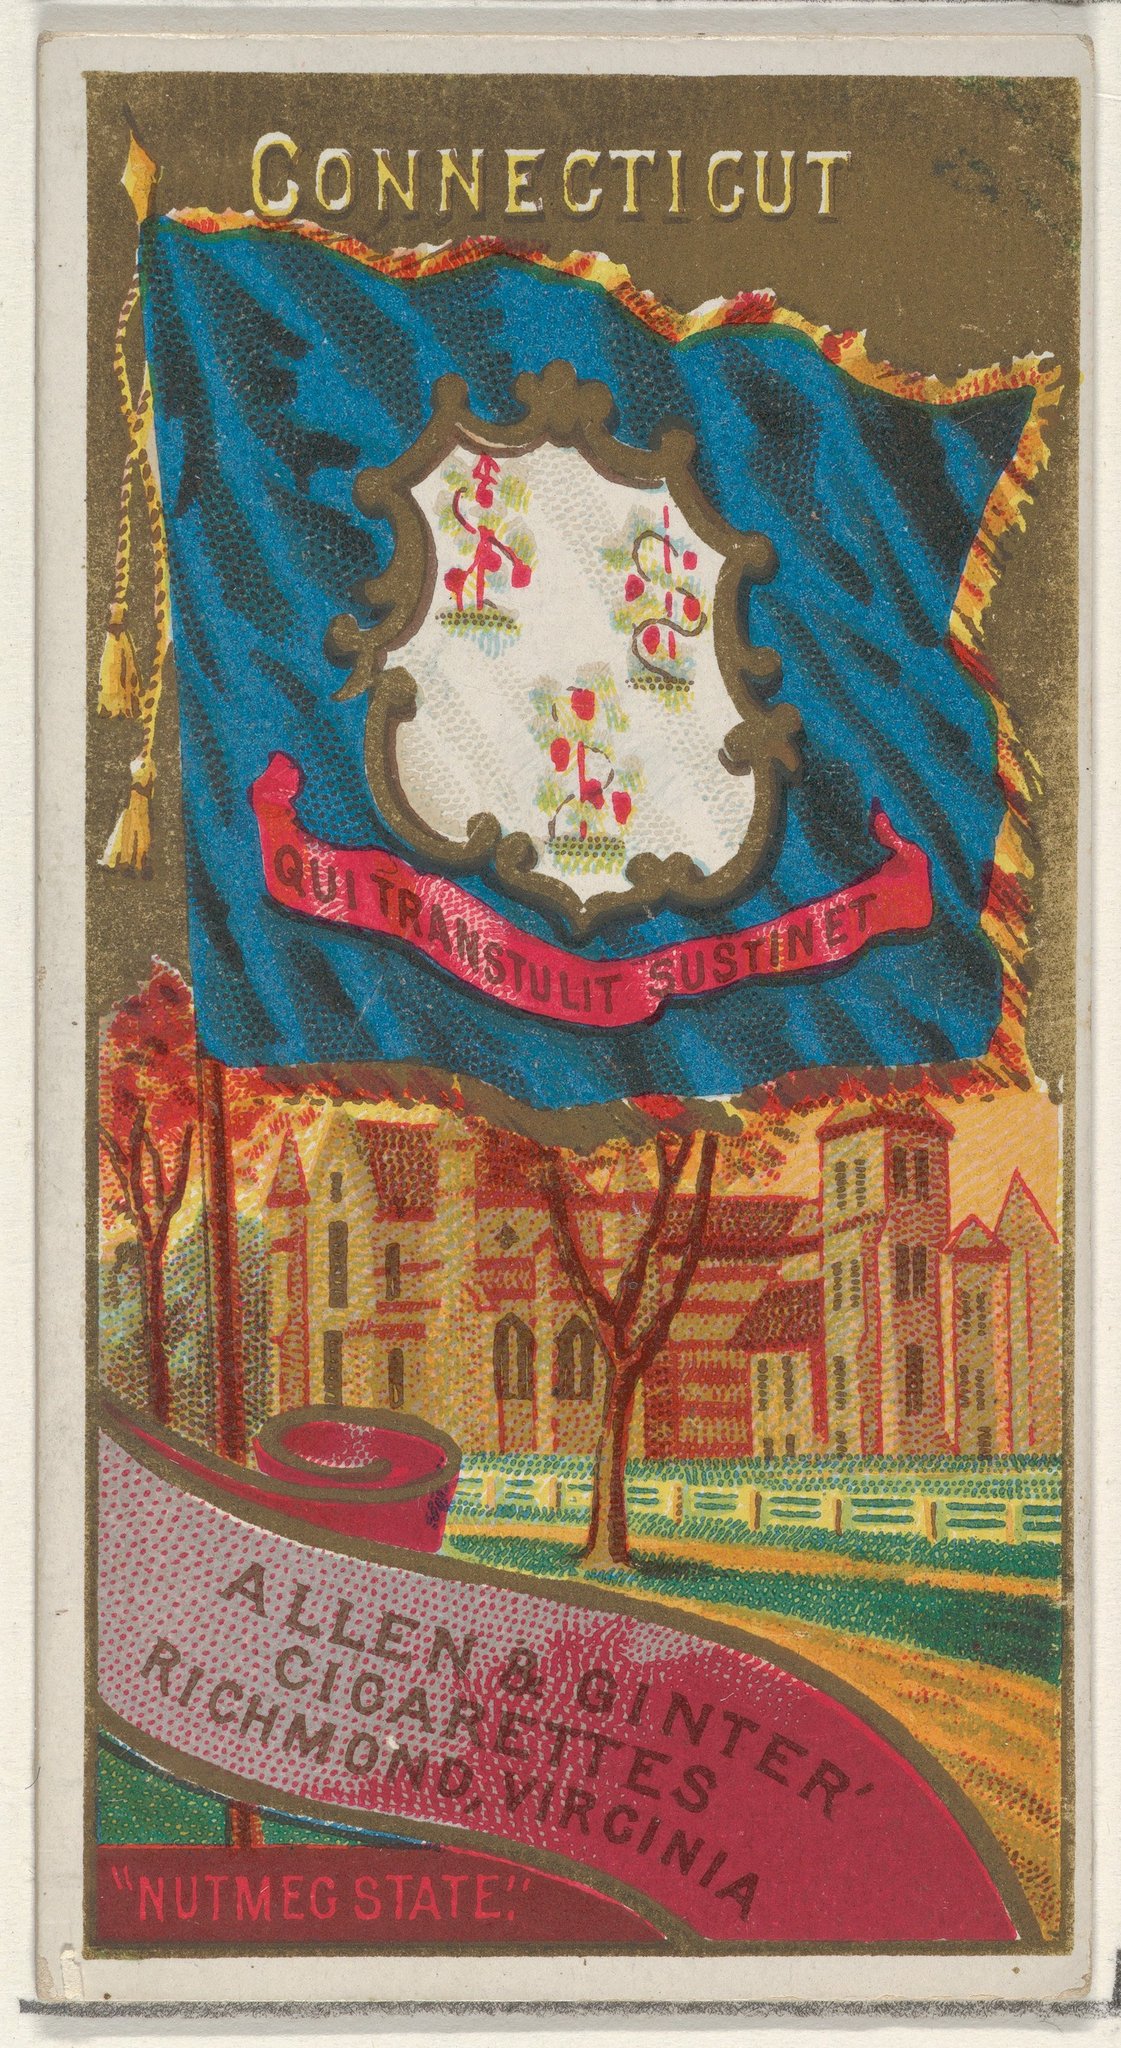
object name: print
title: Connecticut, from Flags of the States and Territories (N11) for Allen & Ginter Cigarettes Brands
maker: allen & ginter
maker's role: publisher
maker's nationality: american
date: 1888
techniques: color lithograph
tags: coat of arms,flags